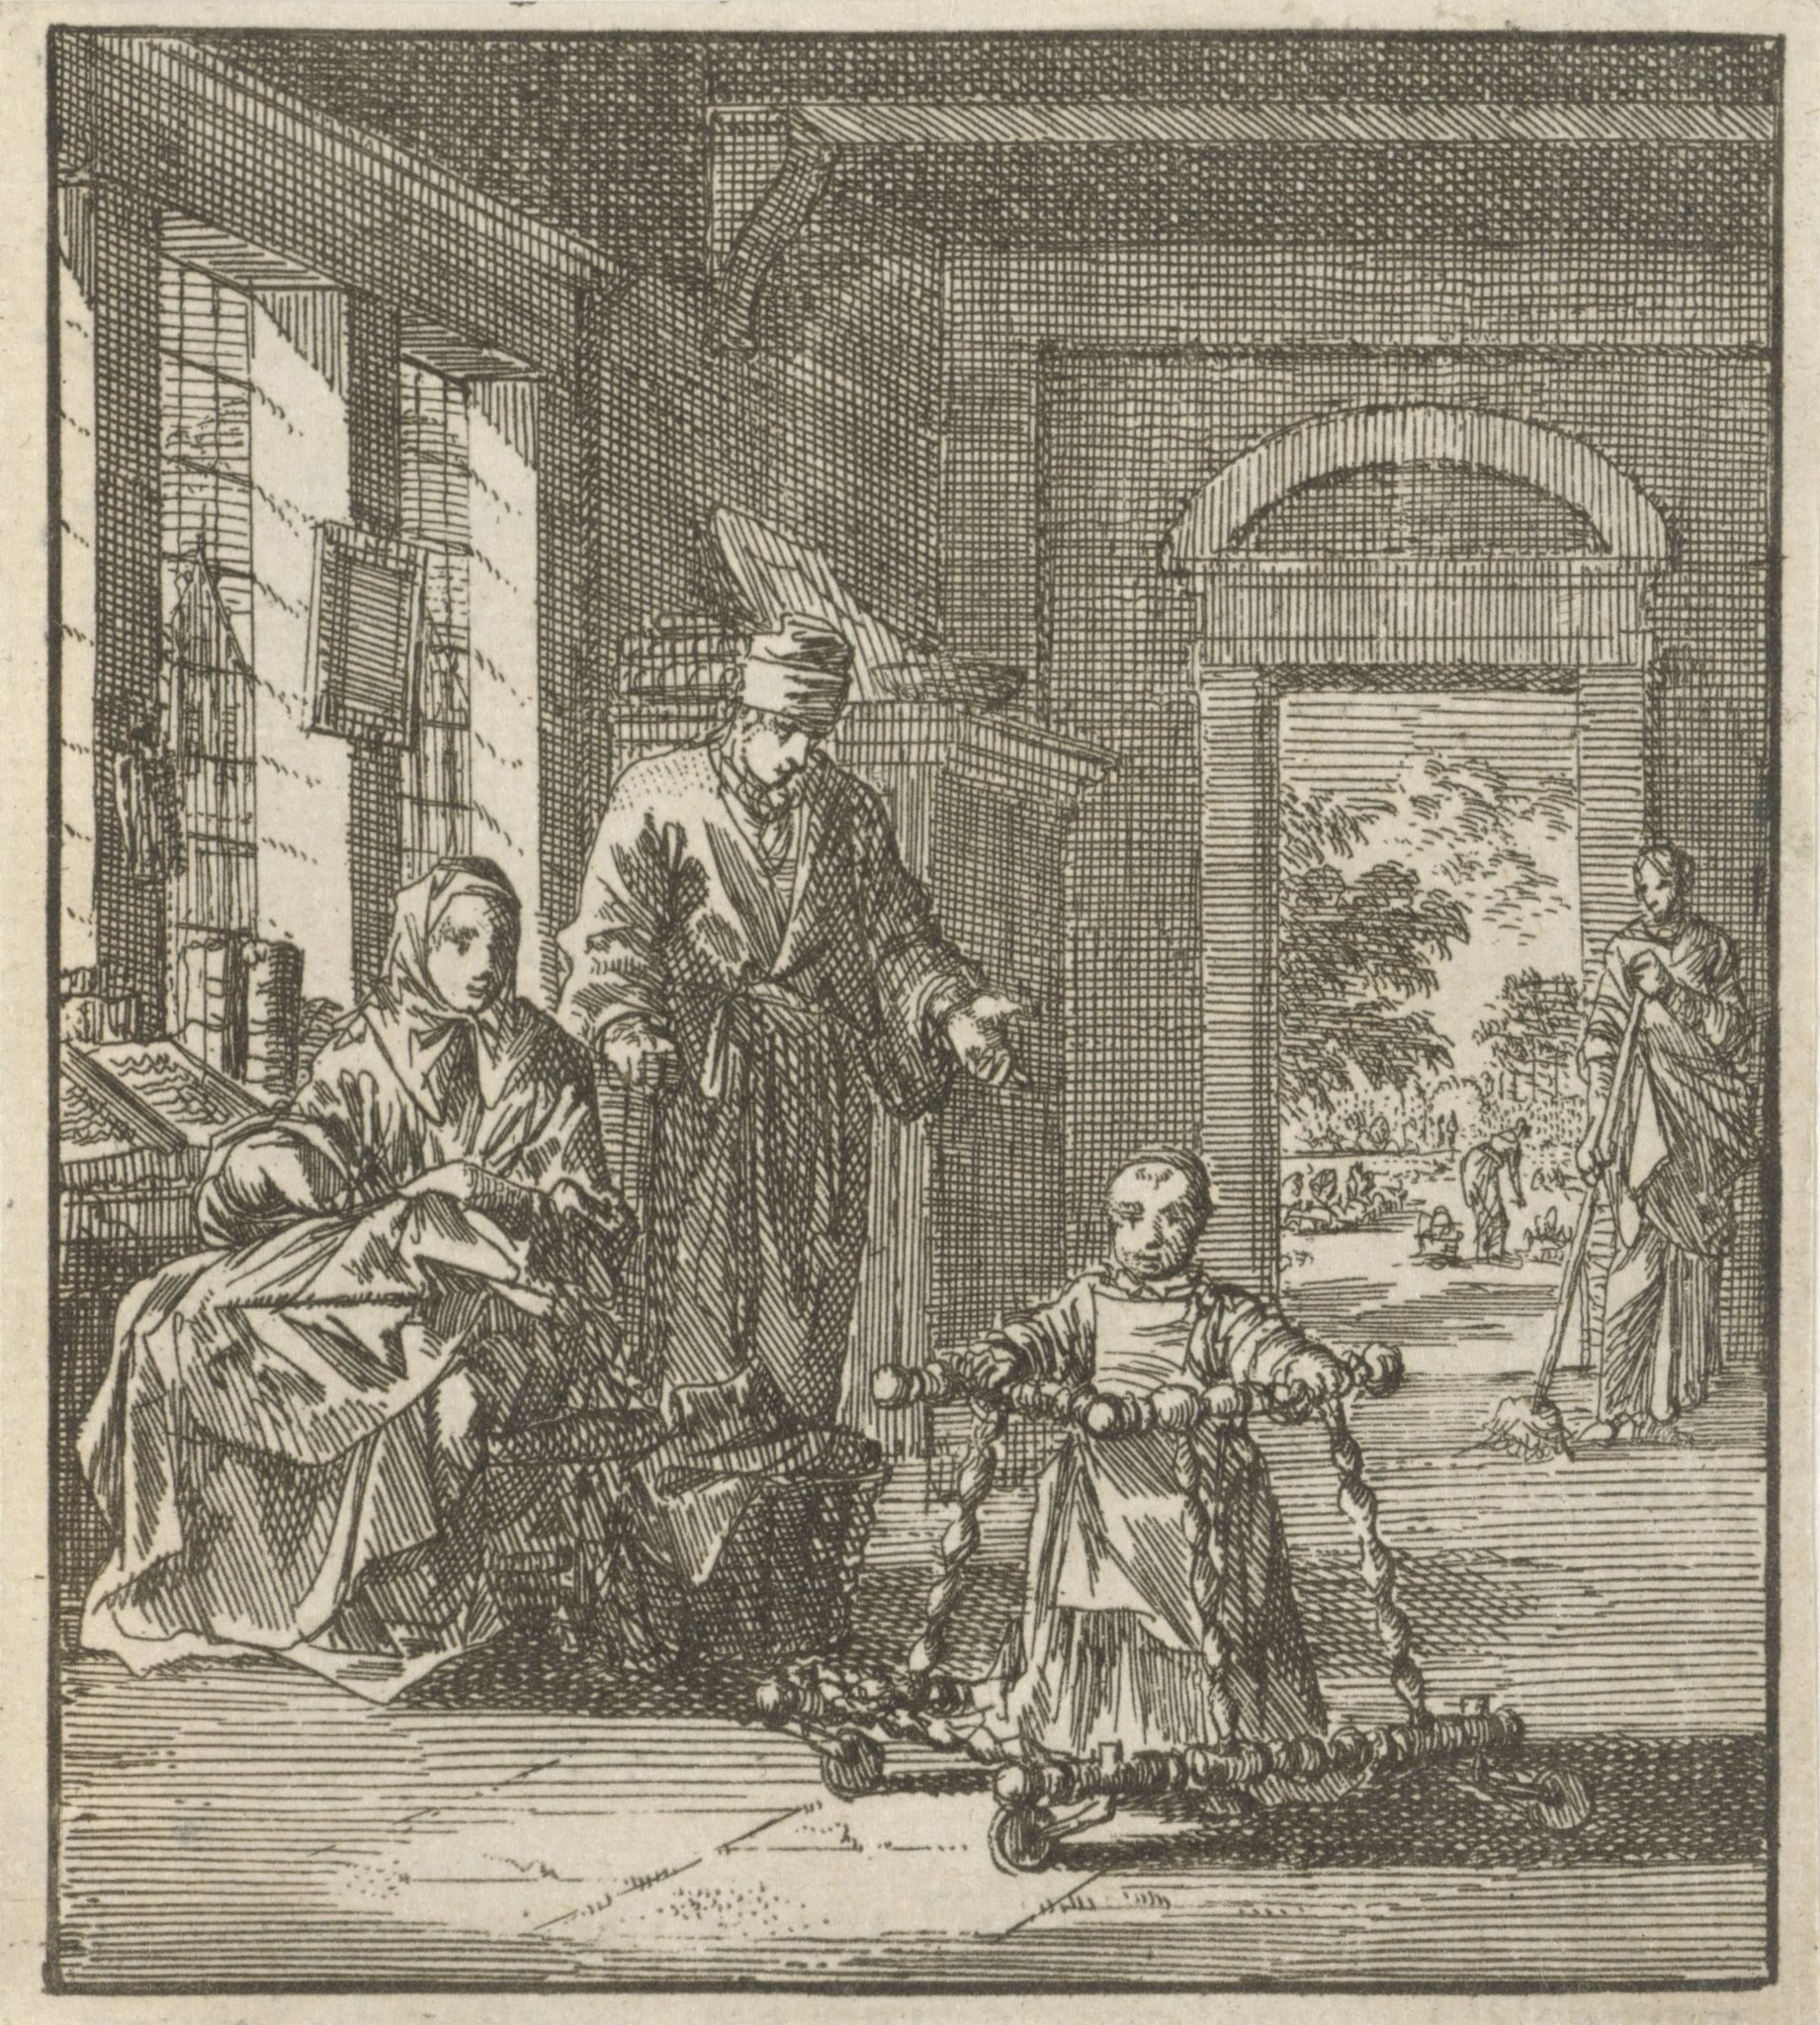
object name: book illustration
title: Ouders aanschouwen hun kind dat leert lopen met een loopwagen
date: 1712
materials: paper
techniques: etching, letterpress printing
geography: amsterdam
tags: parents with their children, implements for learning to walk, go-cart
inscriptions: collector's mark: Lugt 2228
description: Illustratie uit: Luyken, Jan. Des menschen begin, midden en einde. Amsterdam: Wed. Pieter Arentsz II en Cornelis van der Sys, 1712, p. 13.